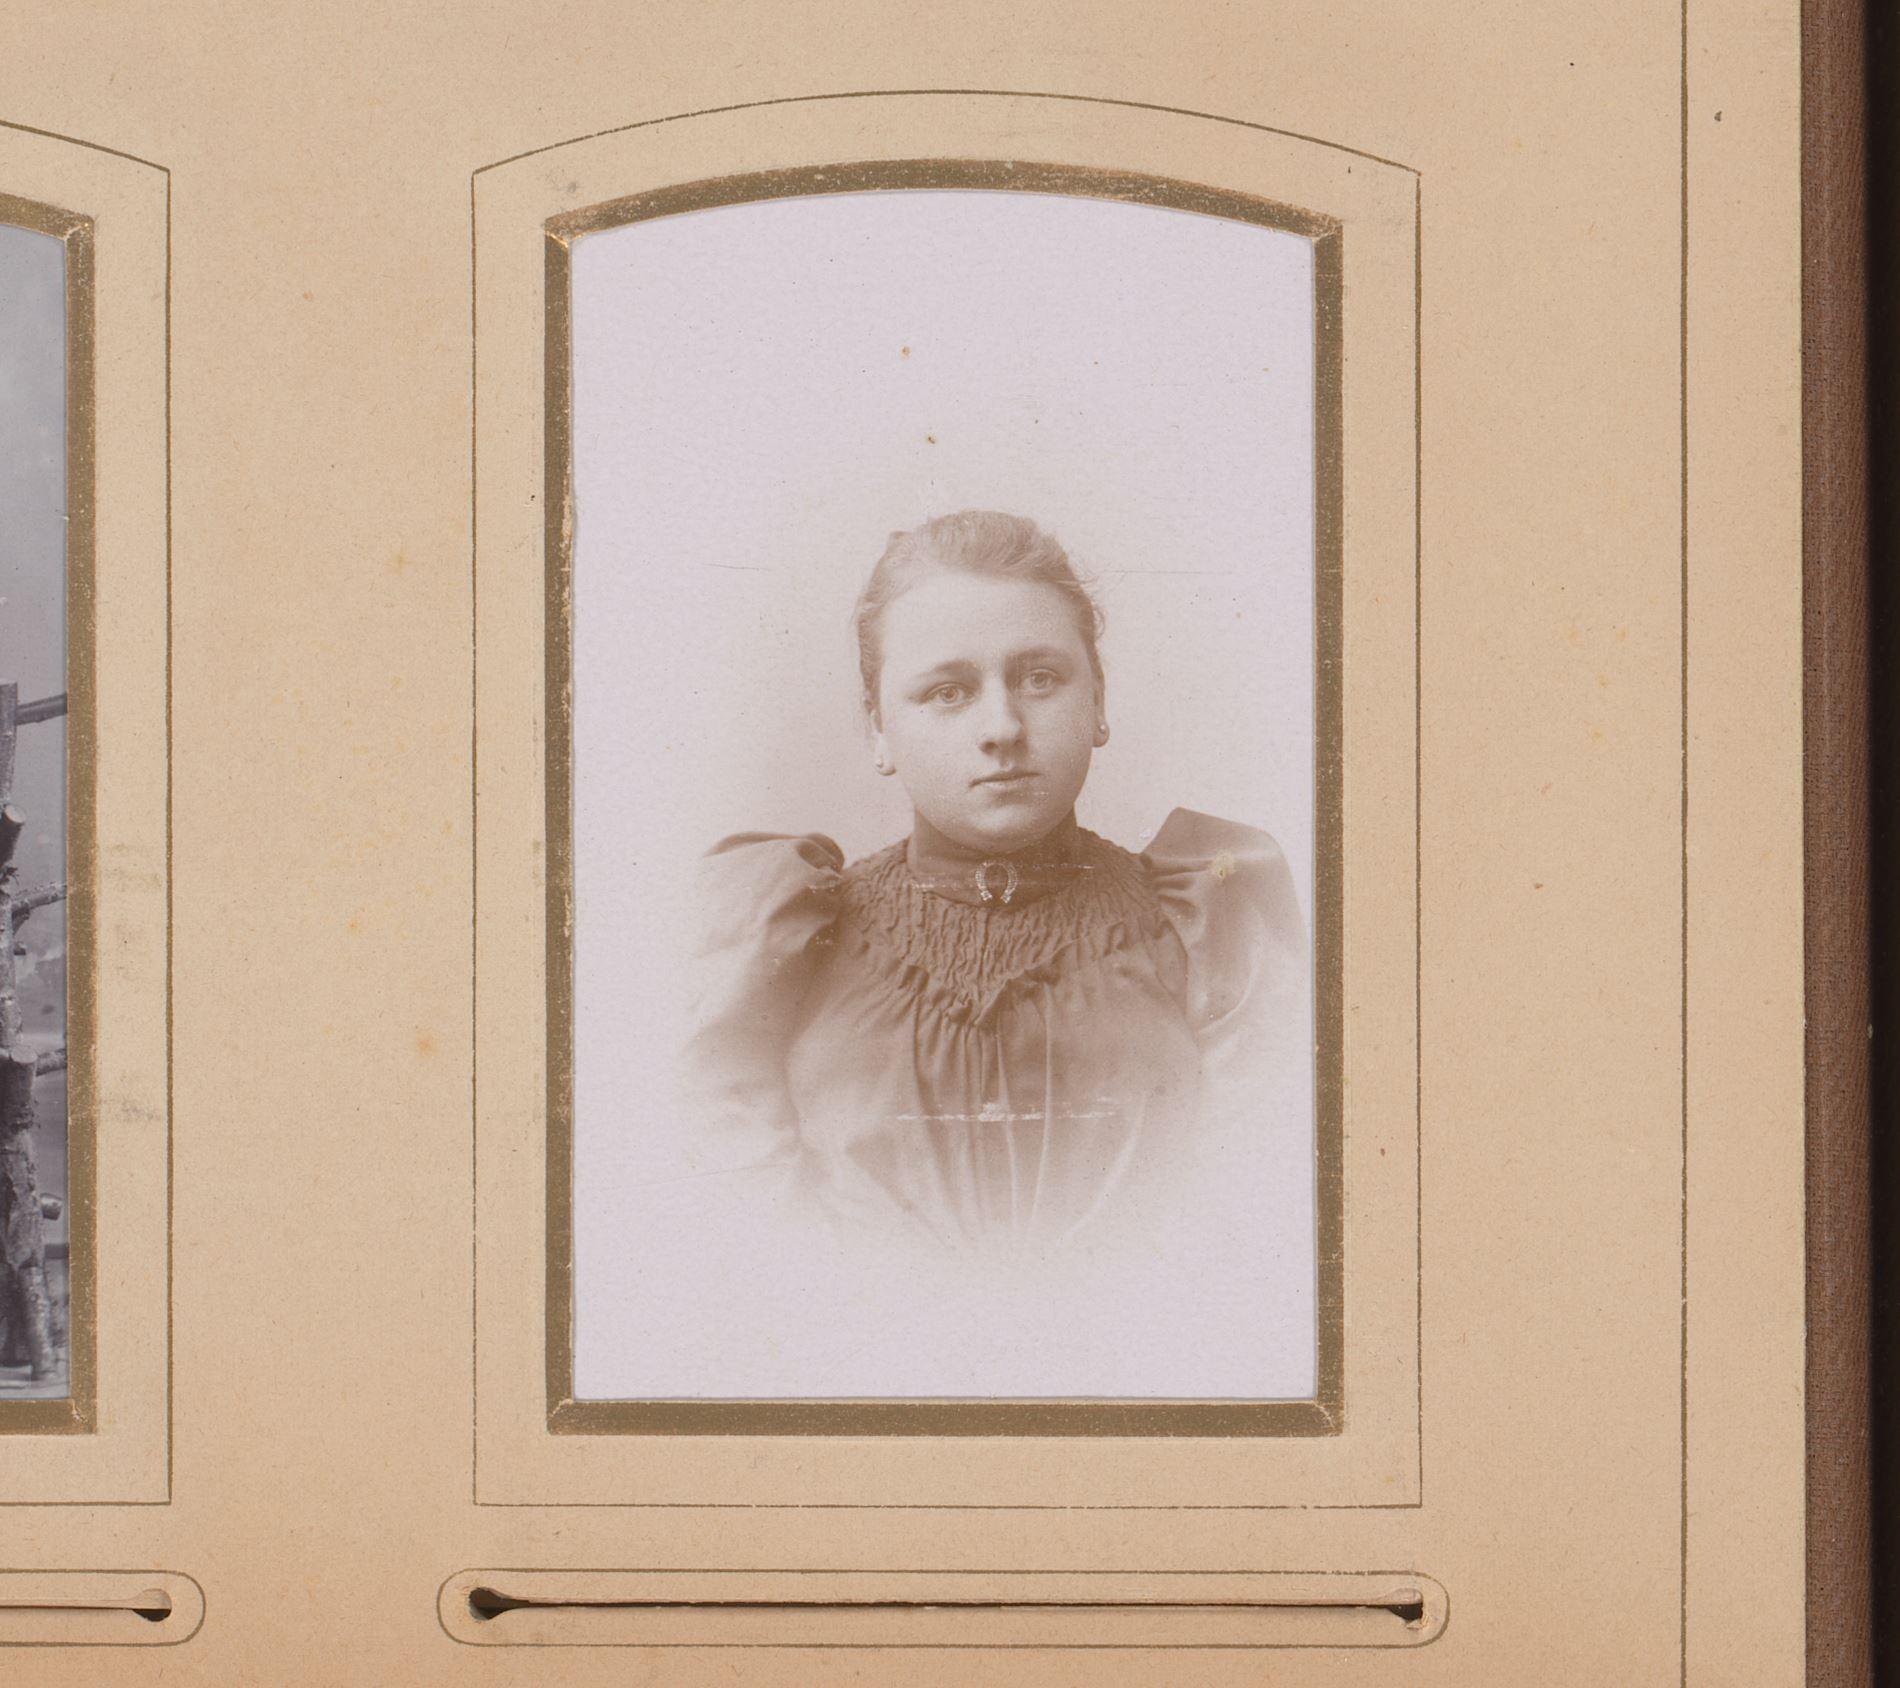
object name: photograph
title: Portret van een meisje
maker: cornelis johannes lodewicus vermeulen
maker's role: fotograaf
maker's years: 1861-1936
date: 1888-1896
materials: cardboard, photographic support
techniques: collodion silver print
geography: amsterdam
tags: historical persons - bb - woman, girl (child between toddler and youth)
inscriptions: inscription: ‘Photographische/ Ateliers/ C.J.L. Vermeulen/ Heerenstraat 6,/ Heiligenweg/ hoek Singel/ Amsterdam./ Specialiteit in vergrootingen.’